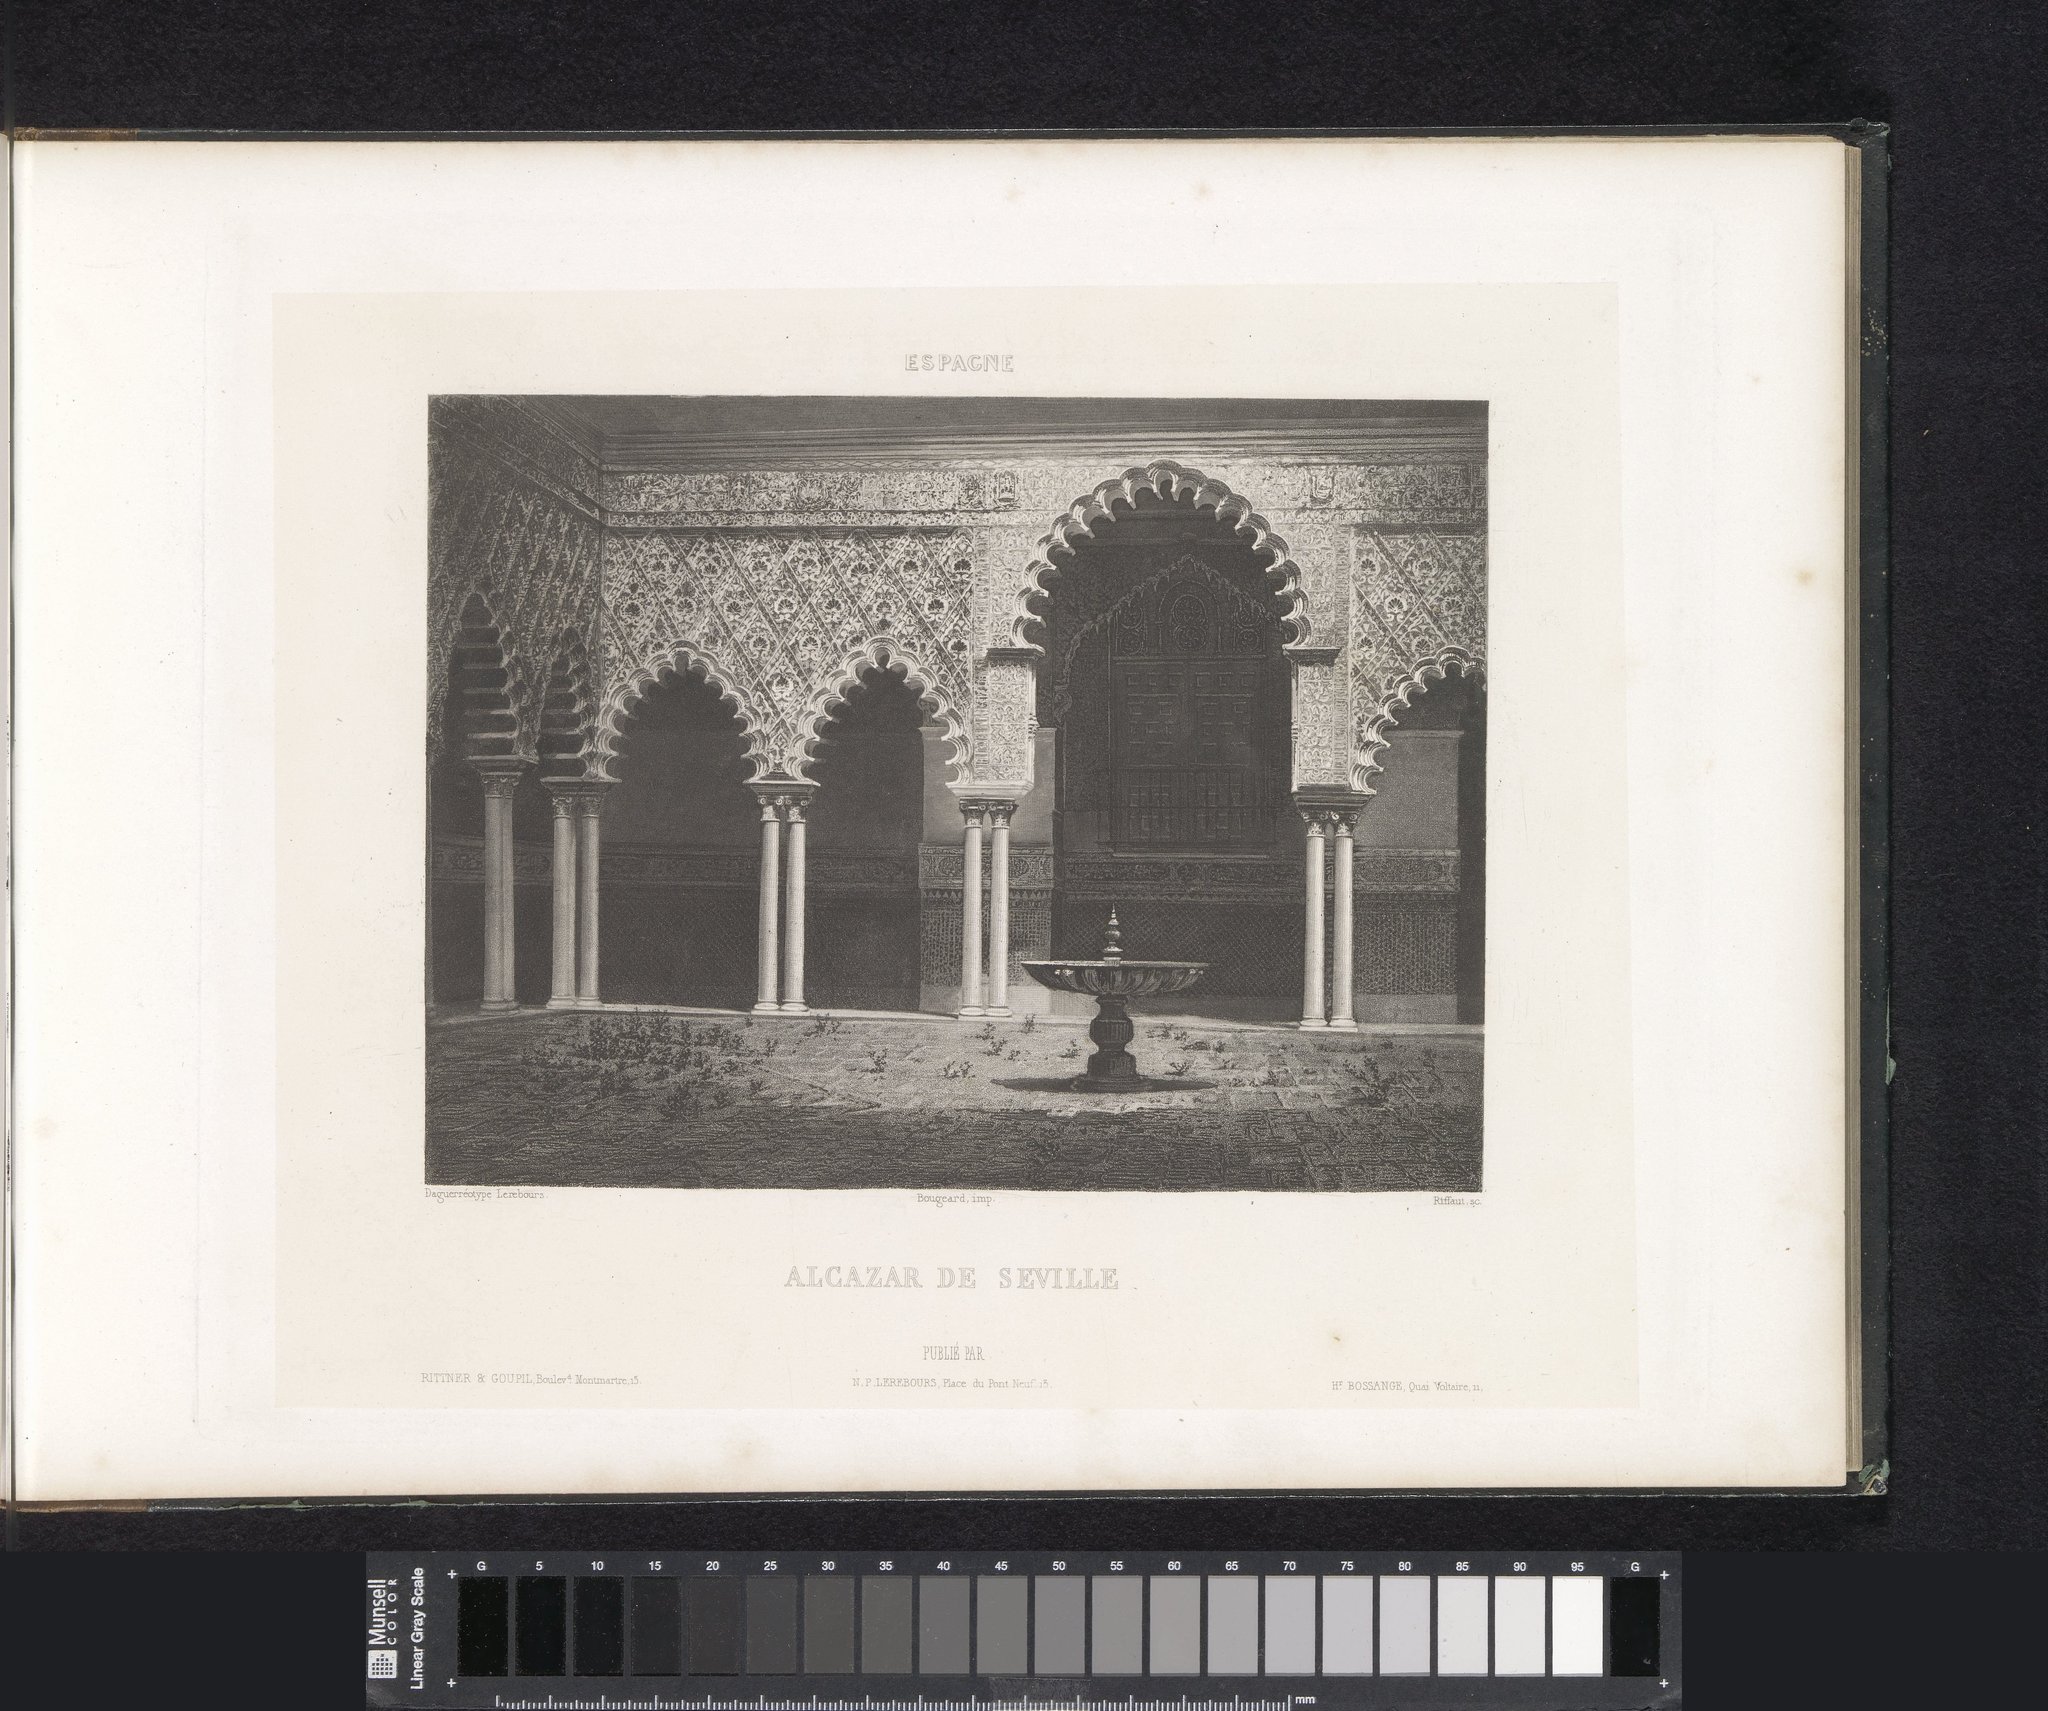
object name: page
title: Espagne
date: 1839-1841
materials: paper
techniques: aquatint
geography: paris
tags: palace, façade of inner court, ornamental fountain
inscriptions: inscription: ‘Rittner & Goupil Boulevd Montmartre 15’, inscription: ‘Hr. Bossance Quai Voltaire 11’, inscription: ‘N.P. Lerebours Place du Pont Neuf 15’